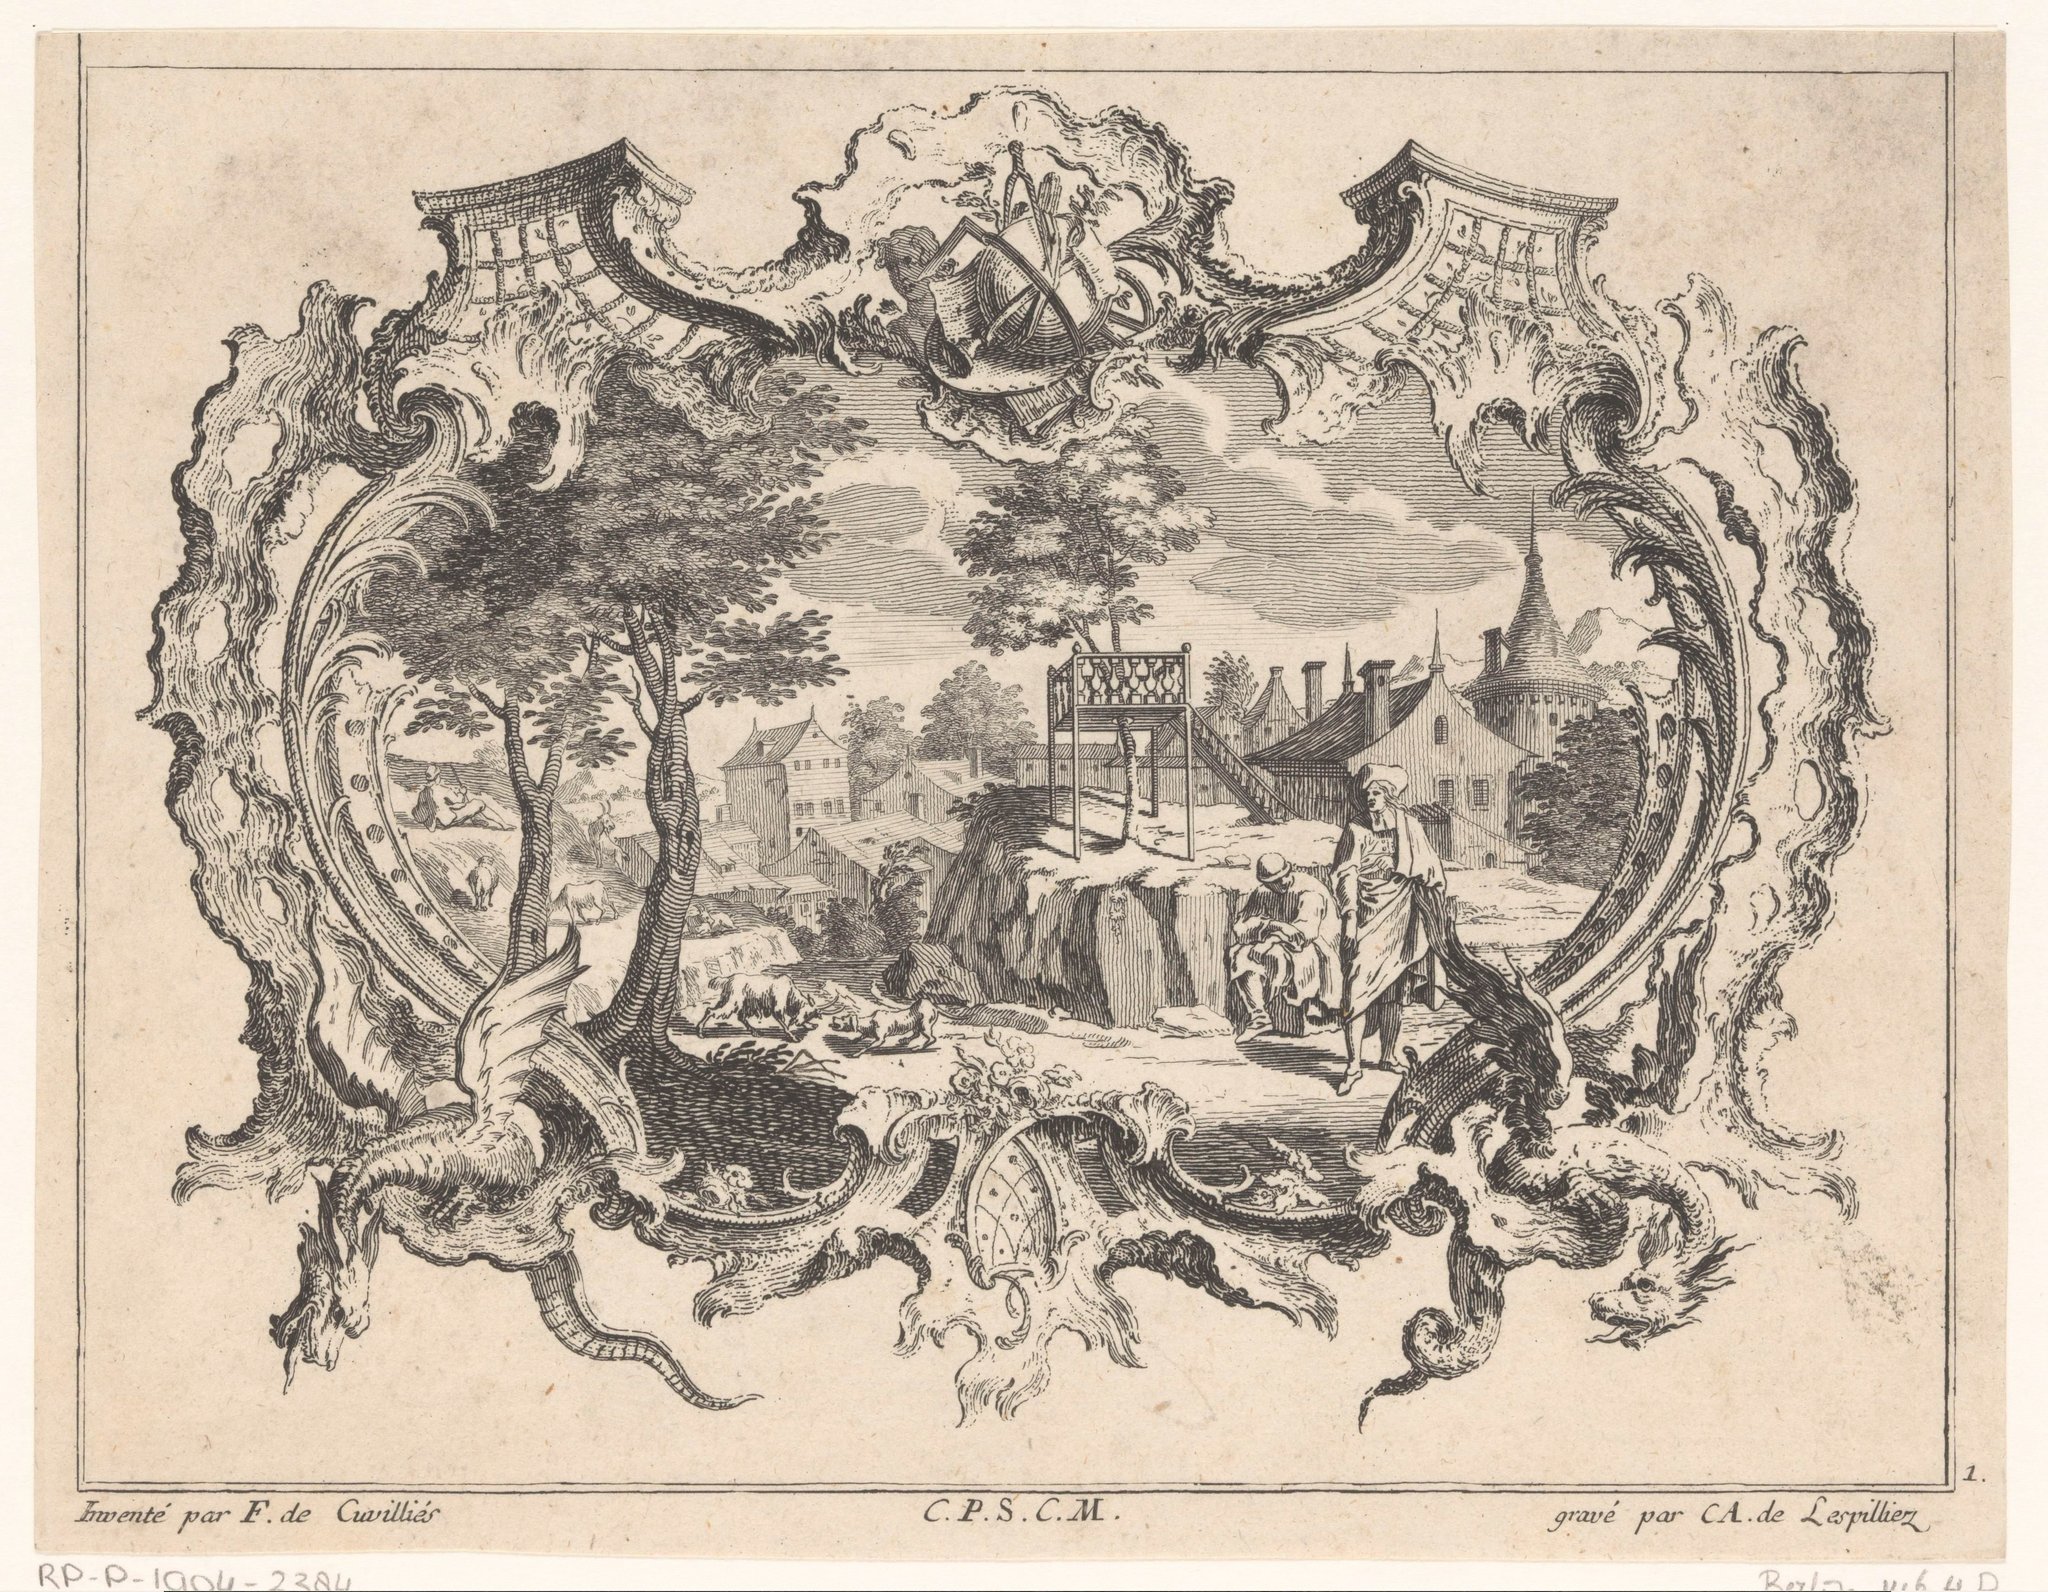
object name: ornament print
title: Herder en twee figuren in een landschap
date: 1745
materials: paper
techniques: etching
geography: germany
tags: herding, herdsman, herdswoman, shepherd, shepherdess, cowherd, etc., village, dragon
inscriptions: collector's mark: Lugt 2228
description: Links op een heuvel zit een herder met zijn vee, rechts een staande en een zittende man en in de achtergrond een dorp. Rondom de voorstelling een omlijsting met draken.